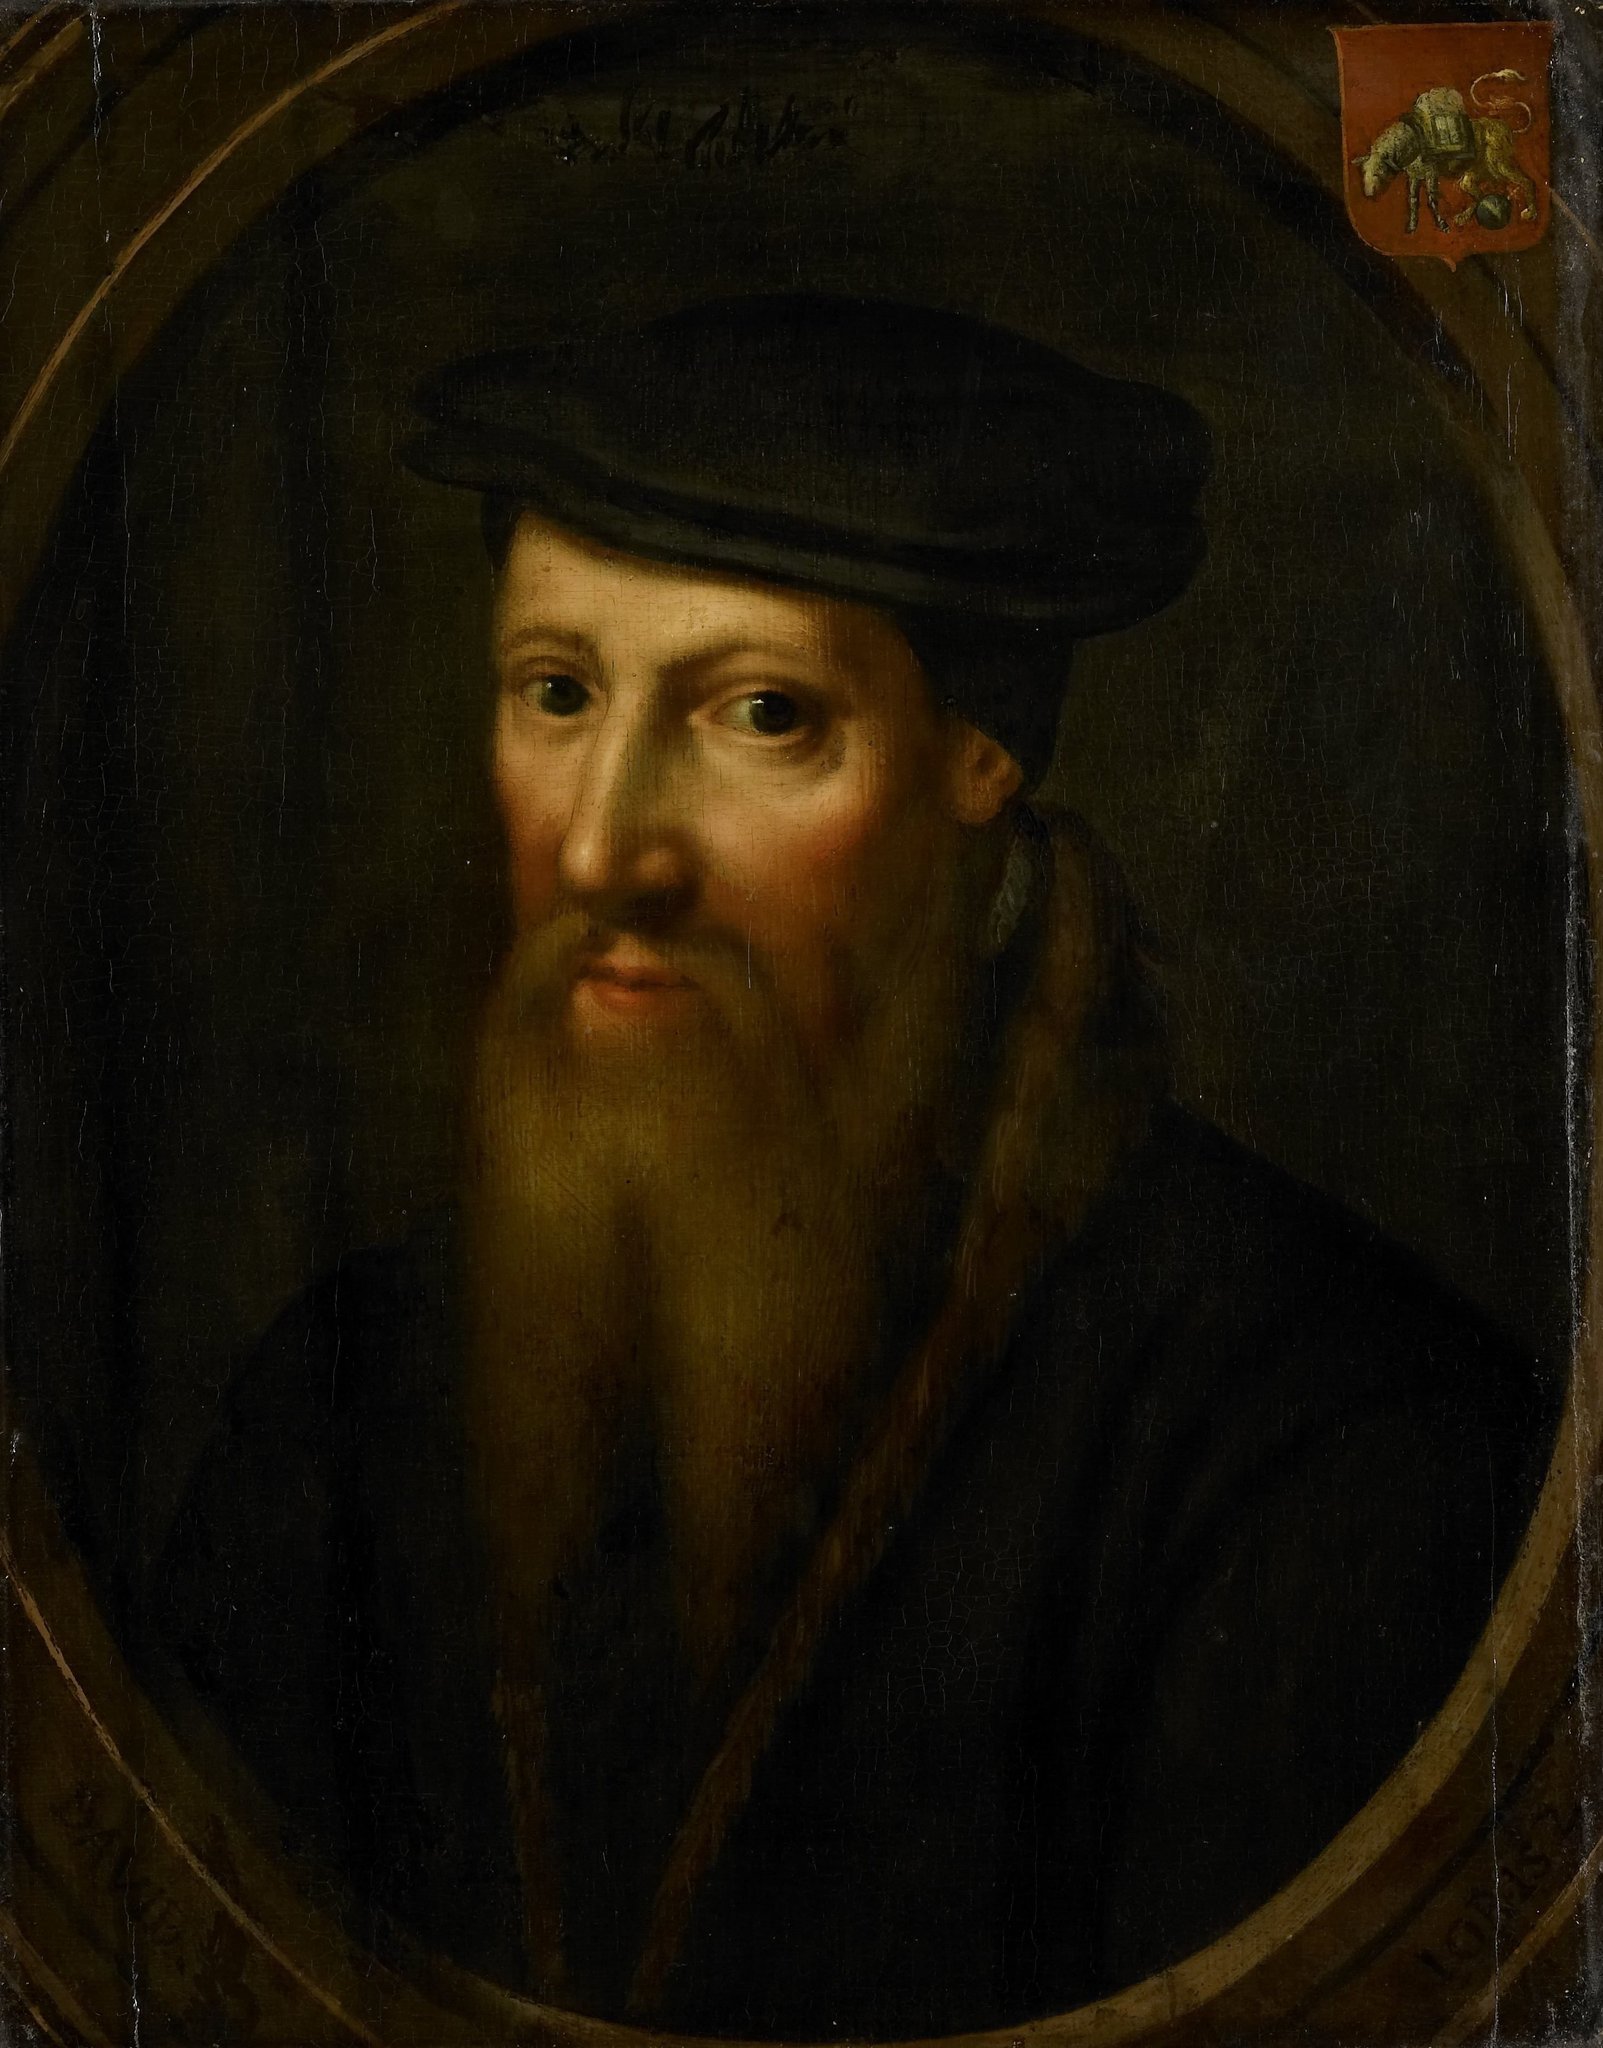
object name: painting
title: Portrait of David Jorisz, Glass Painter in Delft, Fanatic Anabaptist, after 1544 in Basel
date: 1600-1649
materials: oil, panel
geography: low countries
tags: david jorisz., reformation (roman catholic church vs. protestantism), theologian, non-biblical prophets, historical persons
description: Portret van David Jorisz (1501-56). Glasschilder te Delft, later leider van de wederdopers tussen 1535-40 en daarna van het Davidjorisme. Sedert 1544 te Bazel. Buste in ovaal met baret, rechtsboven het familiewapen. Latere kopie naar een origineel uit ca. 1550.